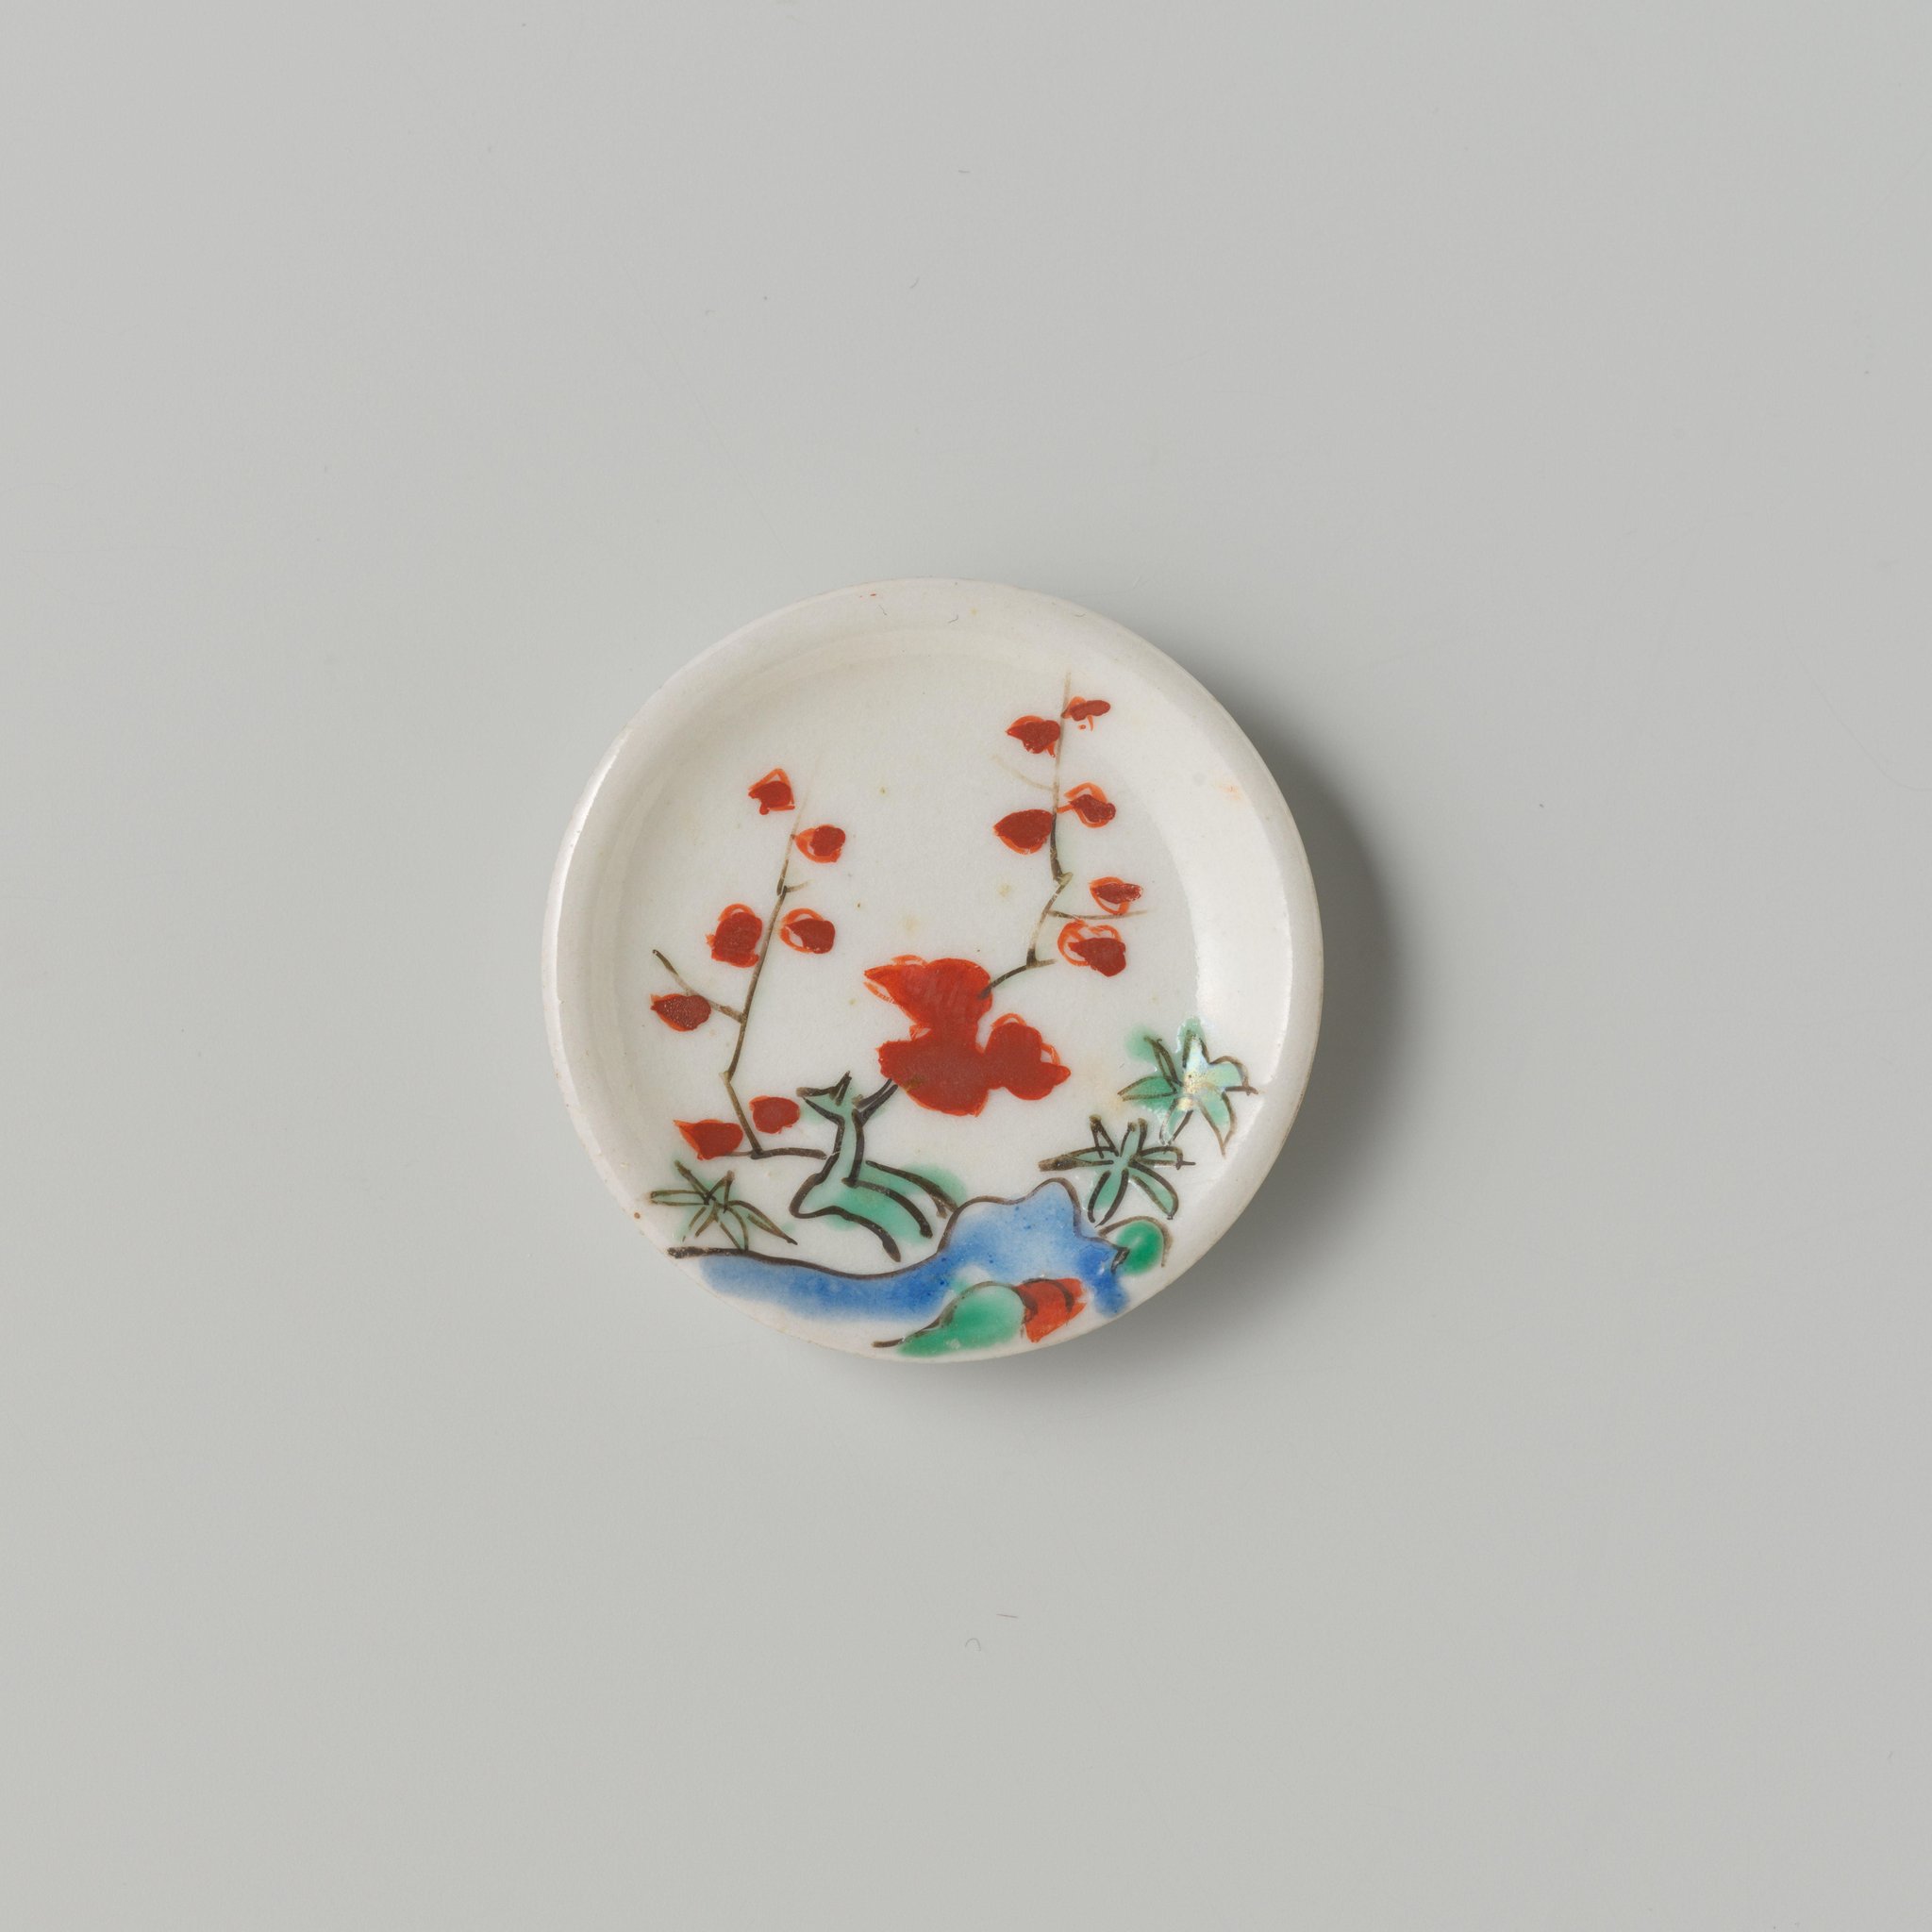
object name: plate dish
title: Schotel van porselein met veelkleurige decoratie in Kakiemonstijl (bloesemtakken en rotsje)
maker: Anonymous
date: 1690-1710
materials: porcelain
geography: arita